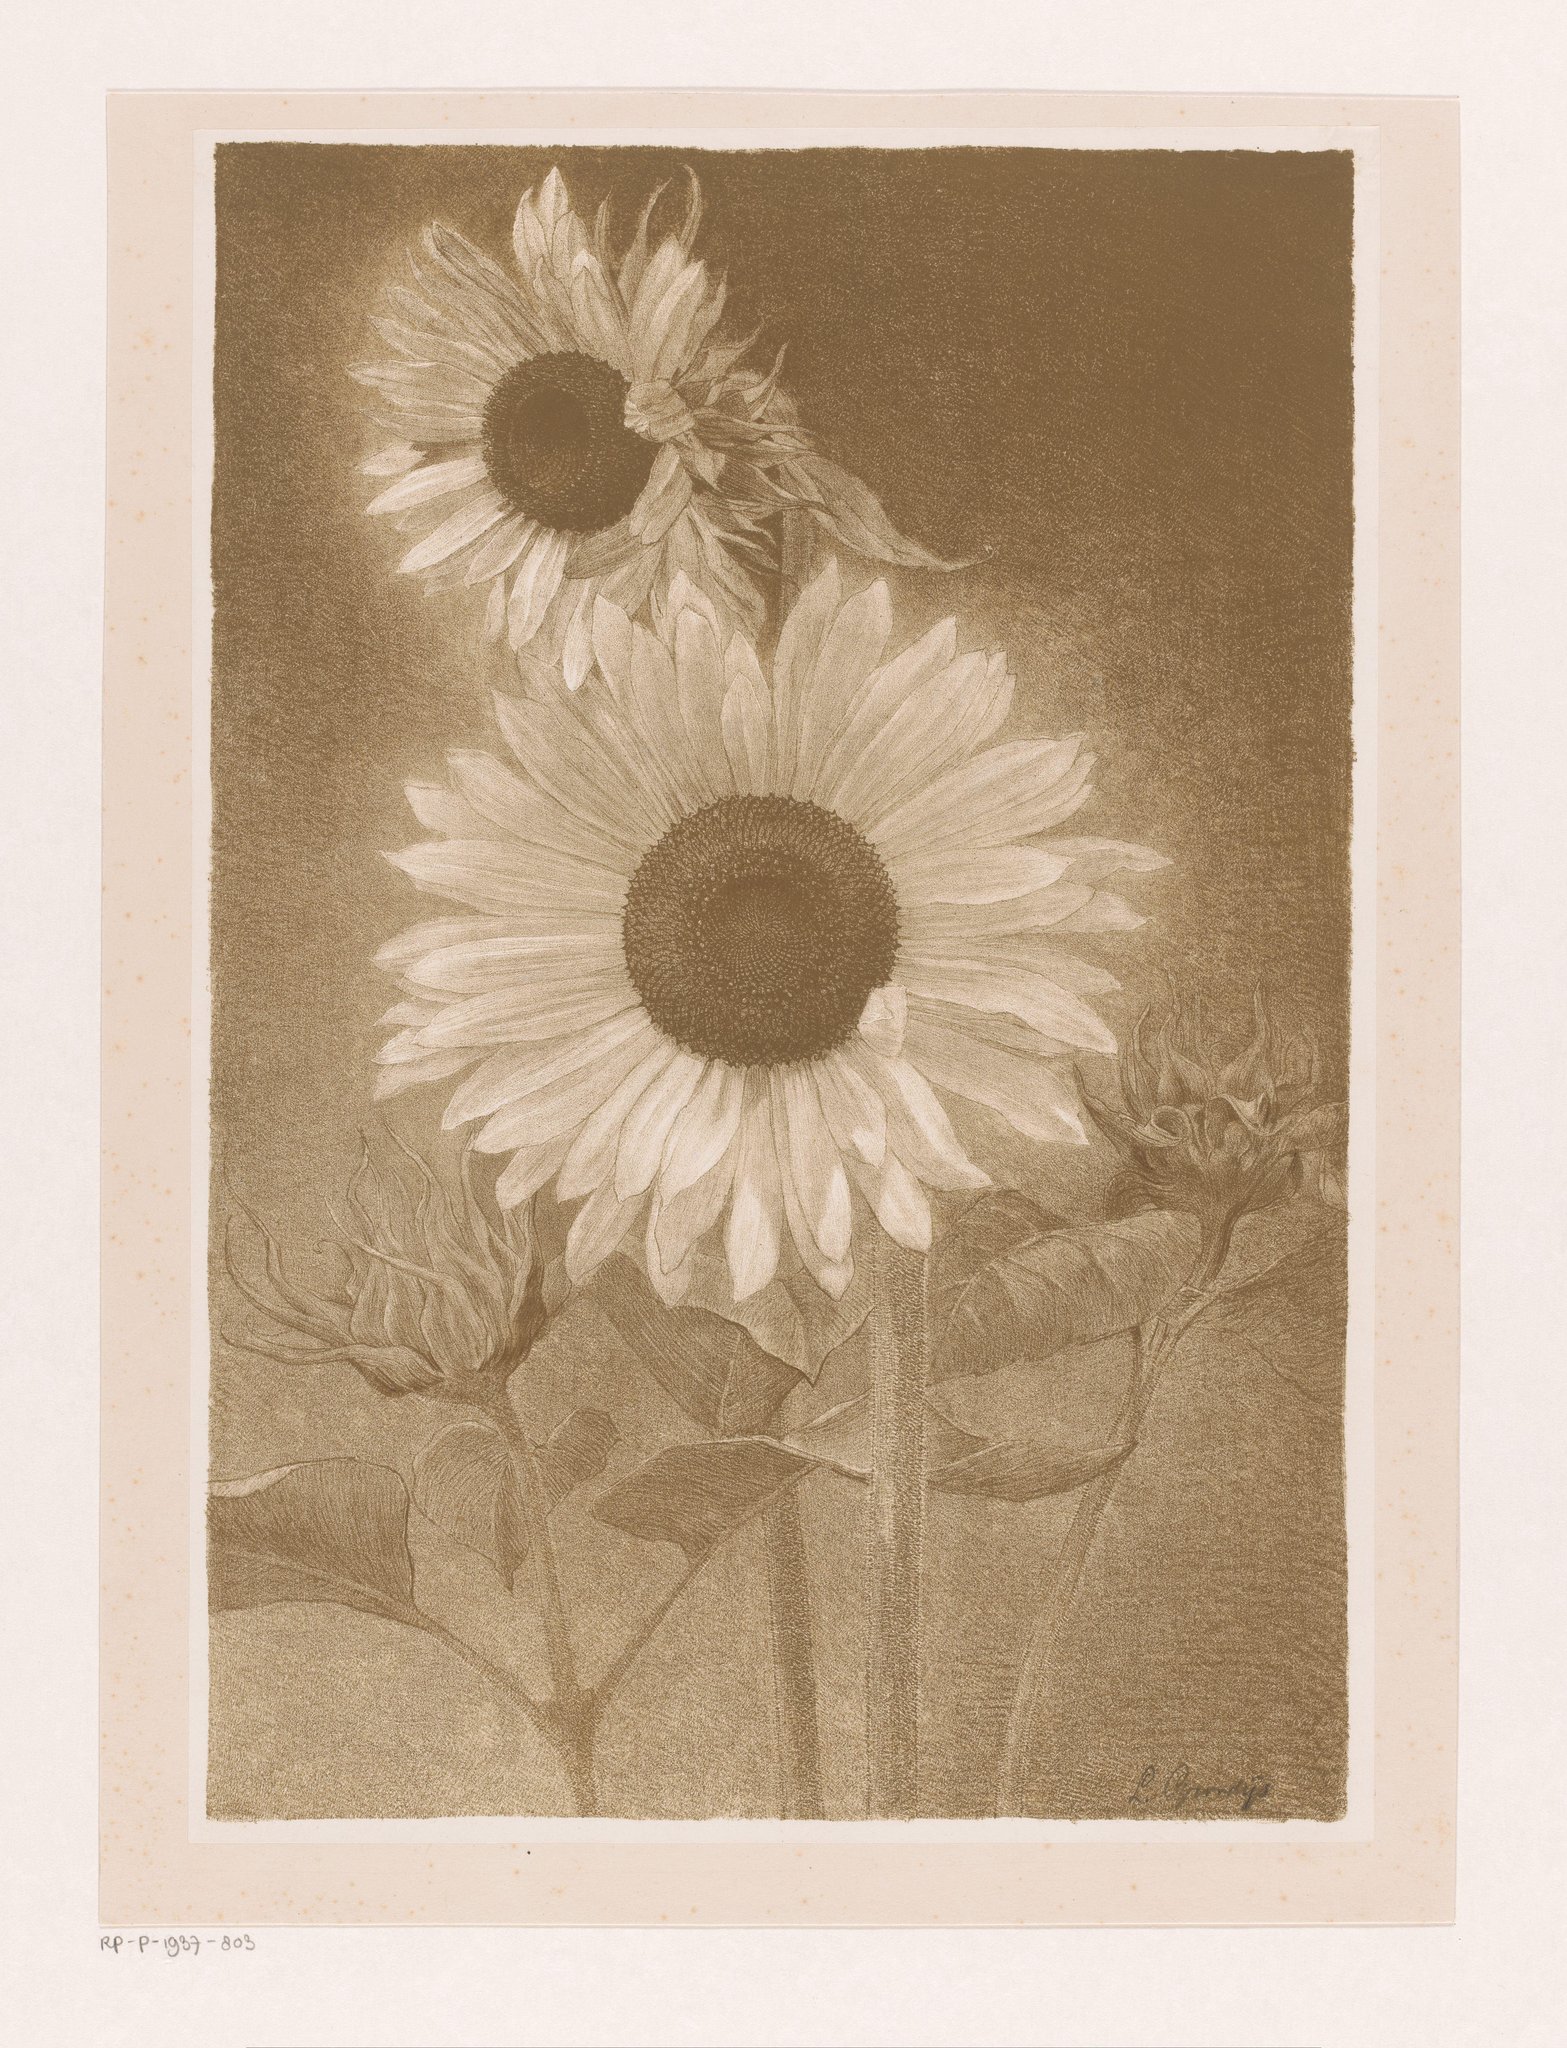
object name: print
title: Twee zonnebloemen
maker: leendert izaac frederikus grondijs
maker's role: print maker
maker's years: 1857-1944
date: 1876-1937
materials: paper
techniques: lithograph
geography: netherlands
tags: flowers: sunflower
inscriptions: collector's mark: Lugt 2228, collector's mark: Lugt 2760